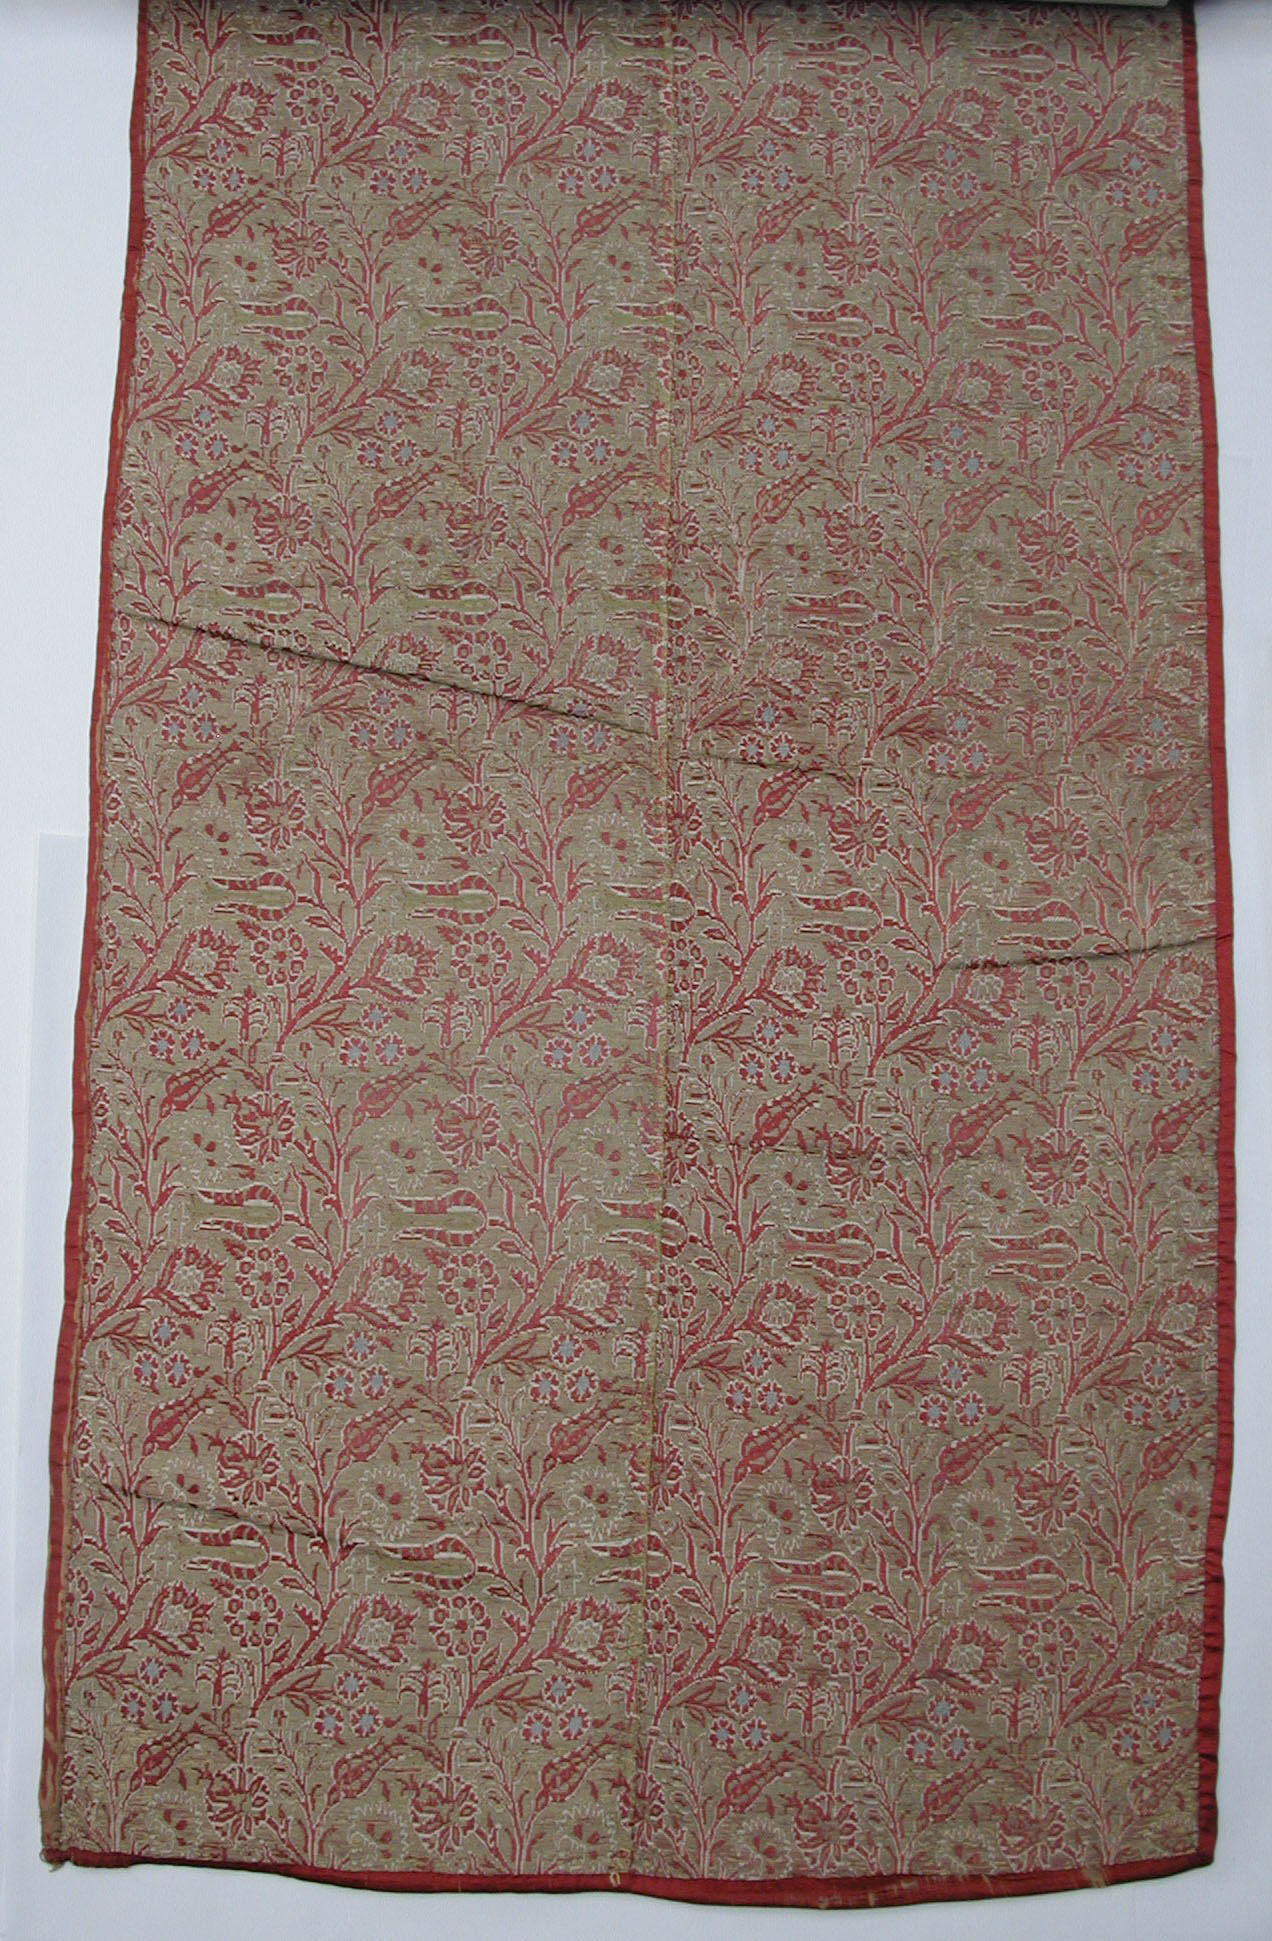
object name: textile fragment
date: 1601-1700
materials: metal thread, silk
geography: turkey